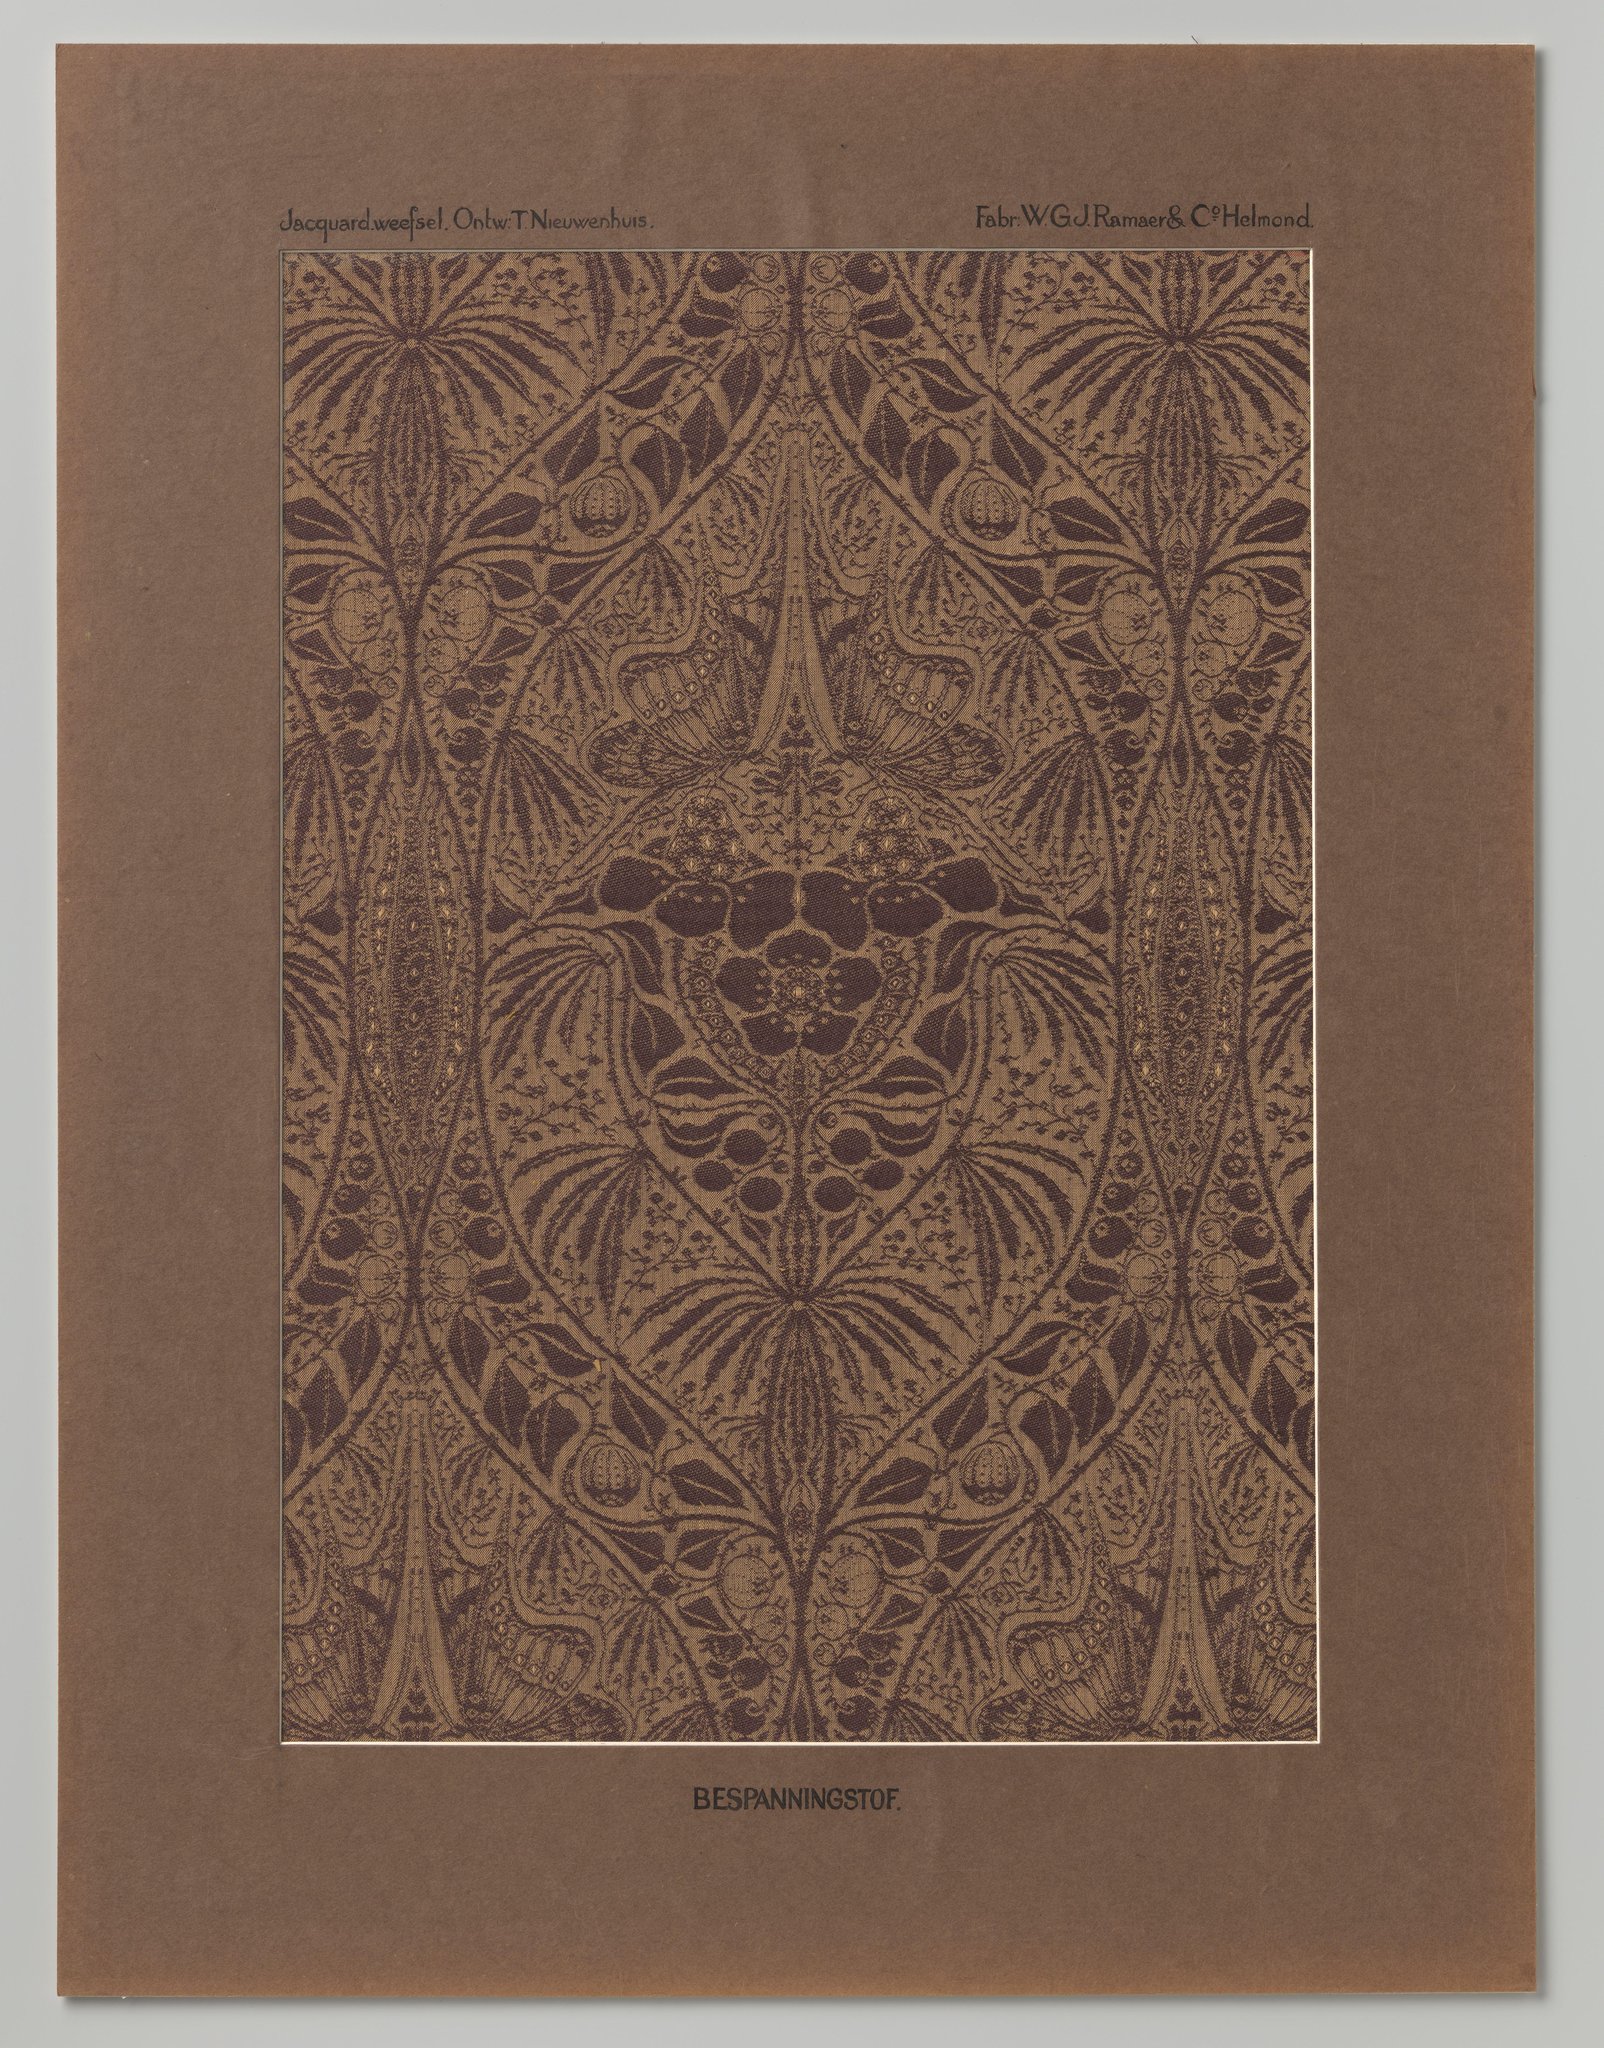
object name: upholstery fabric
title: Staal bespanningsstof naar ontwerp van Theo Nieuwenhuis in passe-partout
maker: theo nieuwenhuis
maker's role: designer, draughtsman, print maker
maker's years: 1866-1951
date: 1910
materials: cardboard, cotton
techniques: jacquard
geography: netherlands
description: Staal bespanningsstof van jacquardgeweven katoen naar ontwerp van Theo Nieuwenhuis. In origineel passe-partout. Het patroon bestaat uit florale motieven met vlinders in spitsvormige medaillons, omgeven door banden met bloem- en bladranken. Bruinpaarse inslag op naturel ketting.